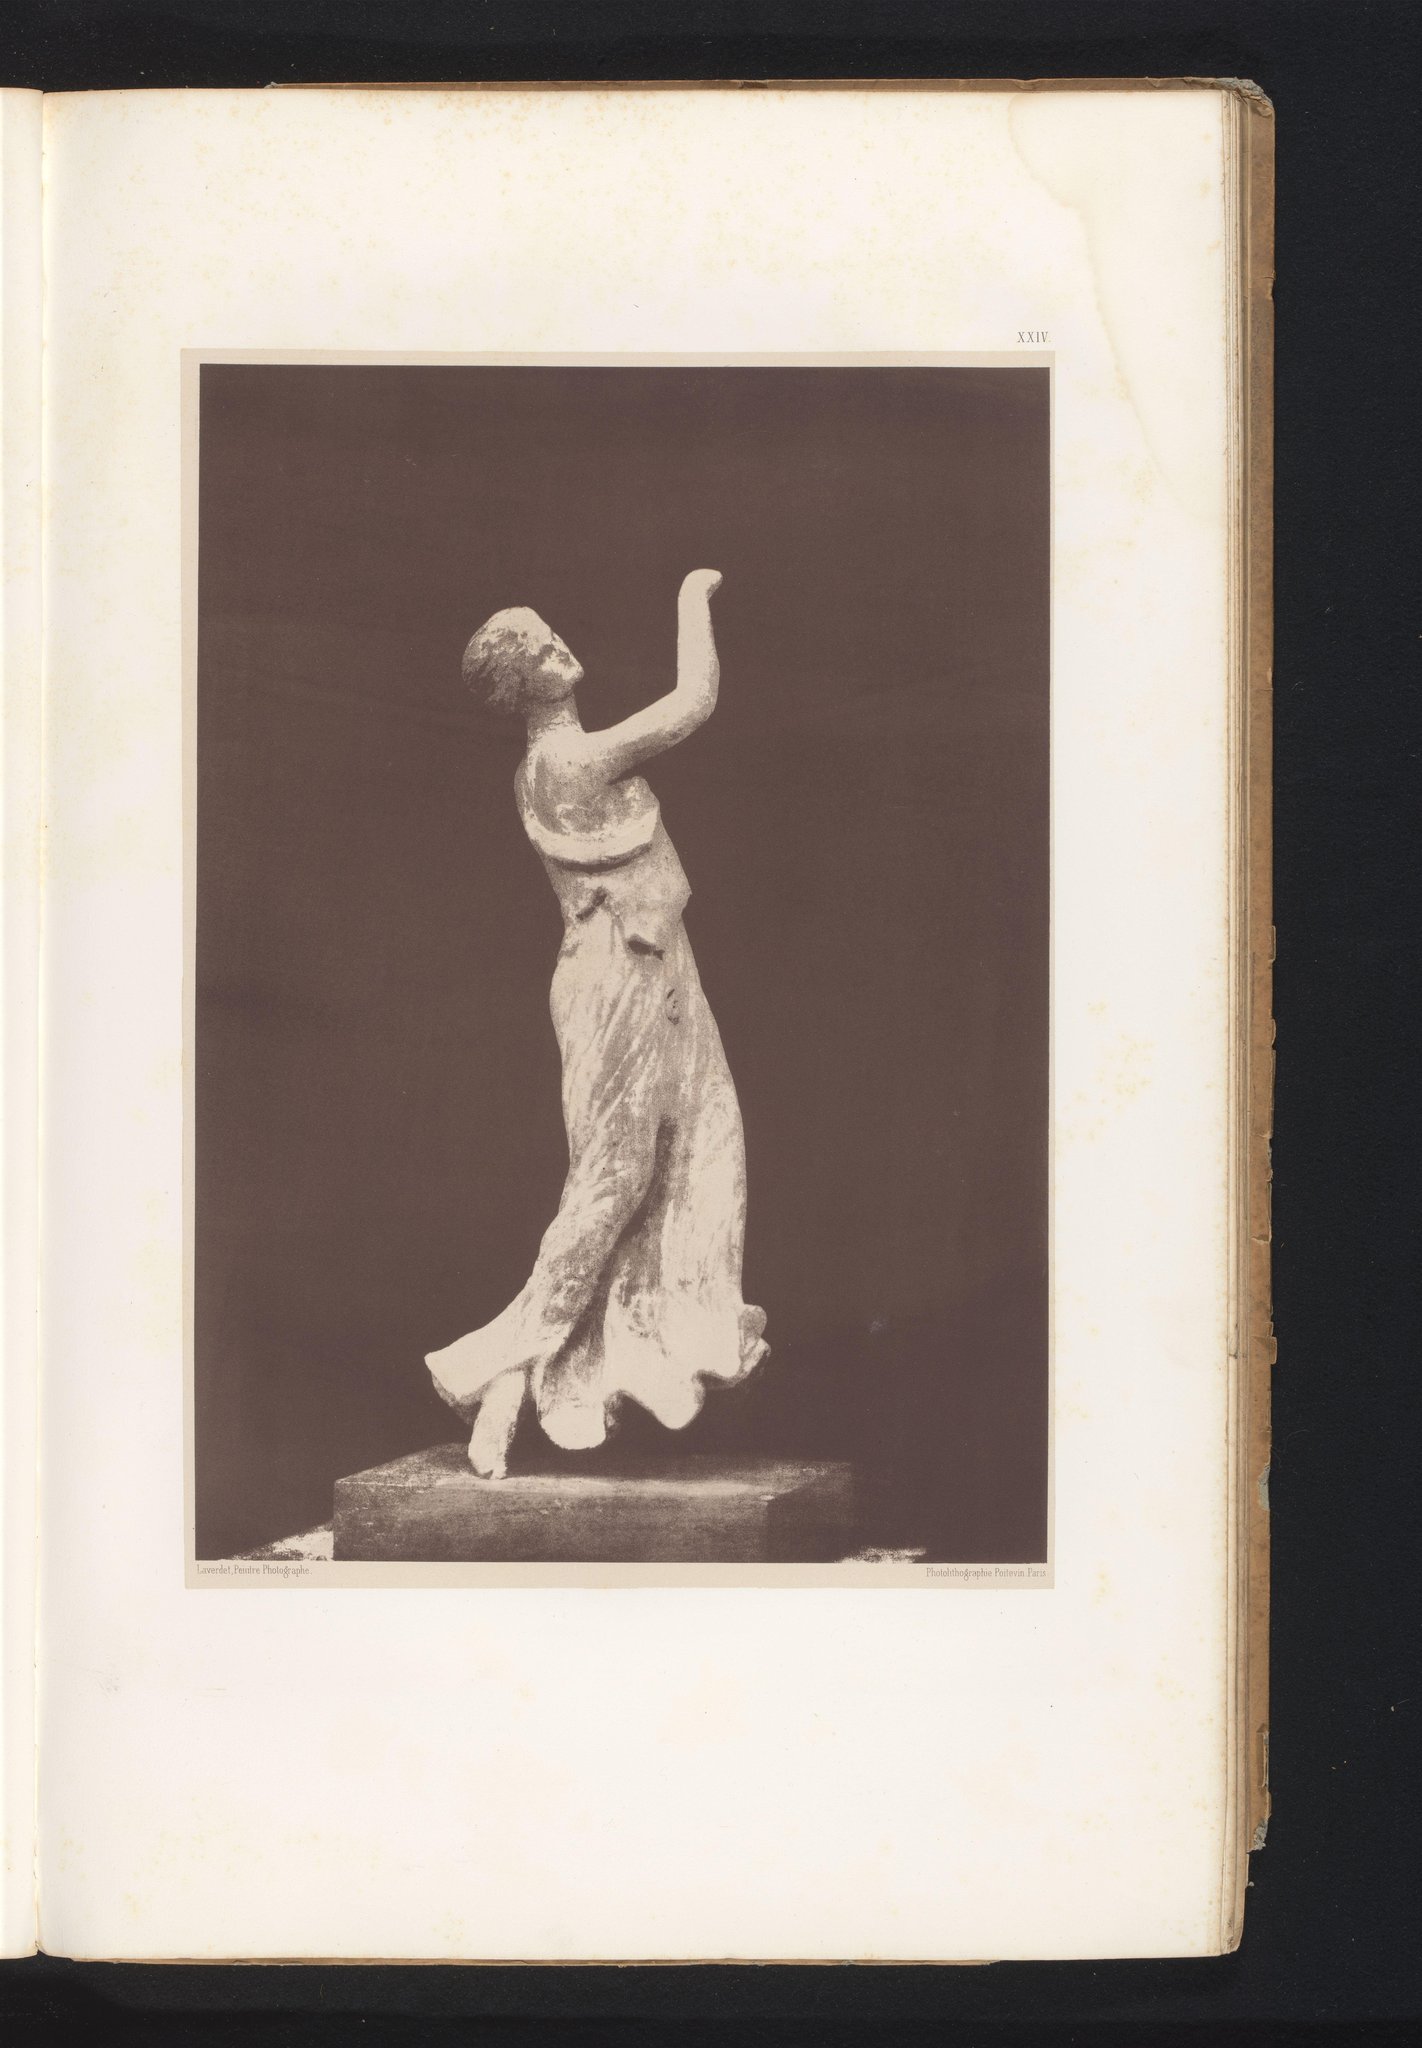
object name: photomechanical print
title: Terracotta sculptuur van een dansende priesteres van Bacchus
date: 1852-1857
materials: paper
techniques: photolithography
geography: paris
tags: piece of sculpture, reproduction of a piece of sculpture (+ clay, sand, etc. ~ arts), maenad(s), female bacchant(es)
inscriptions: number: ‘XXIV.’